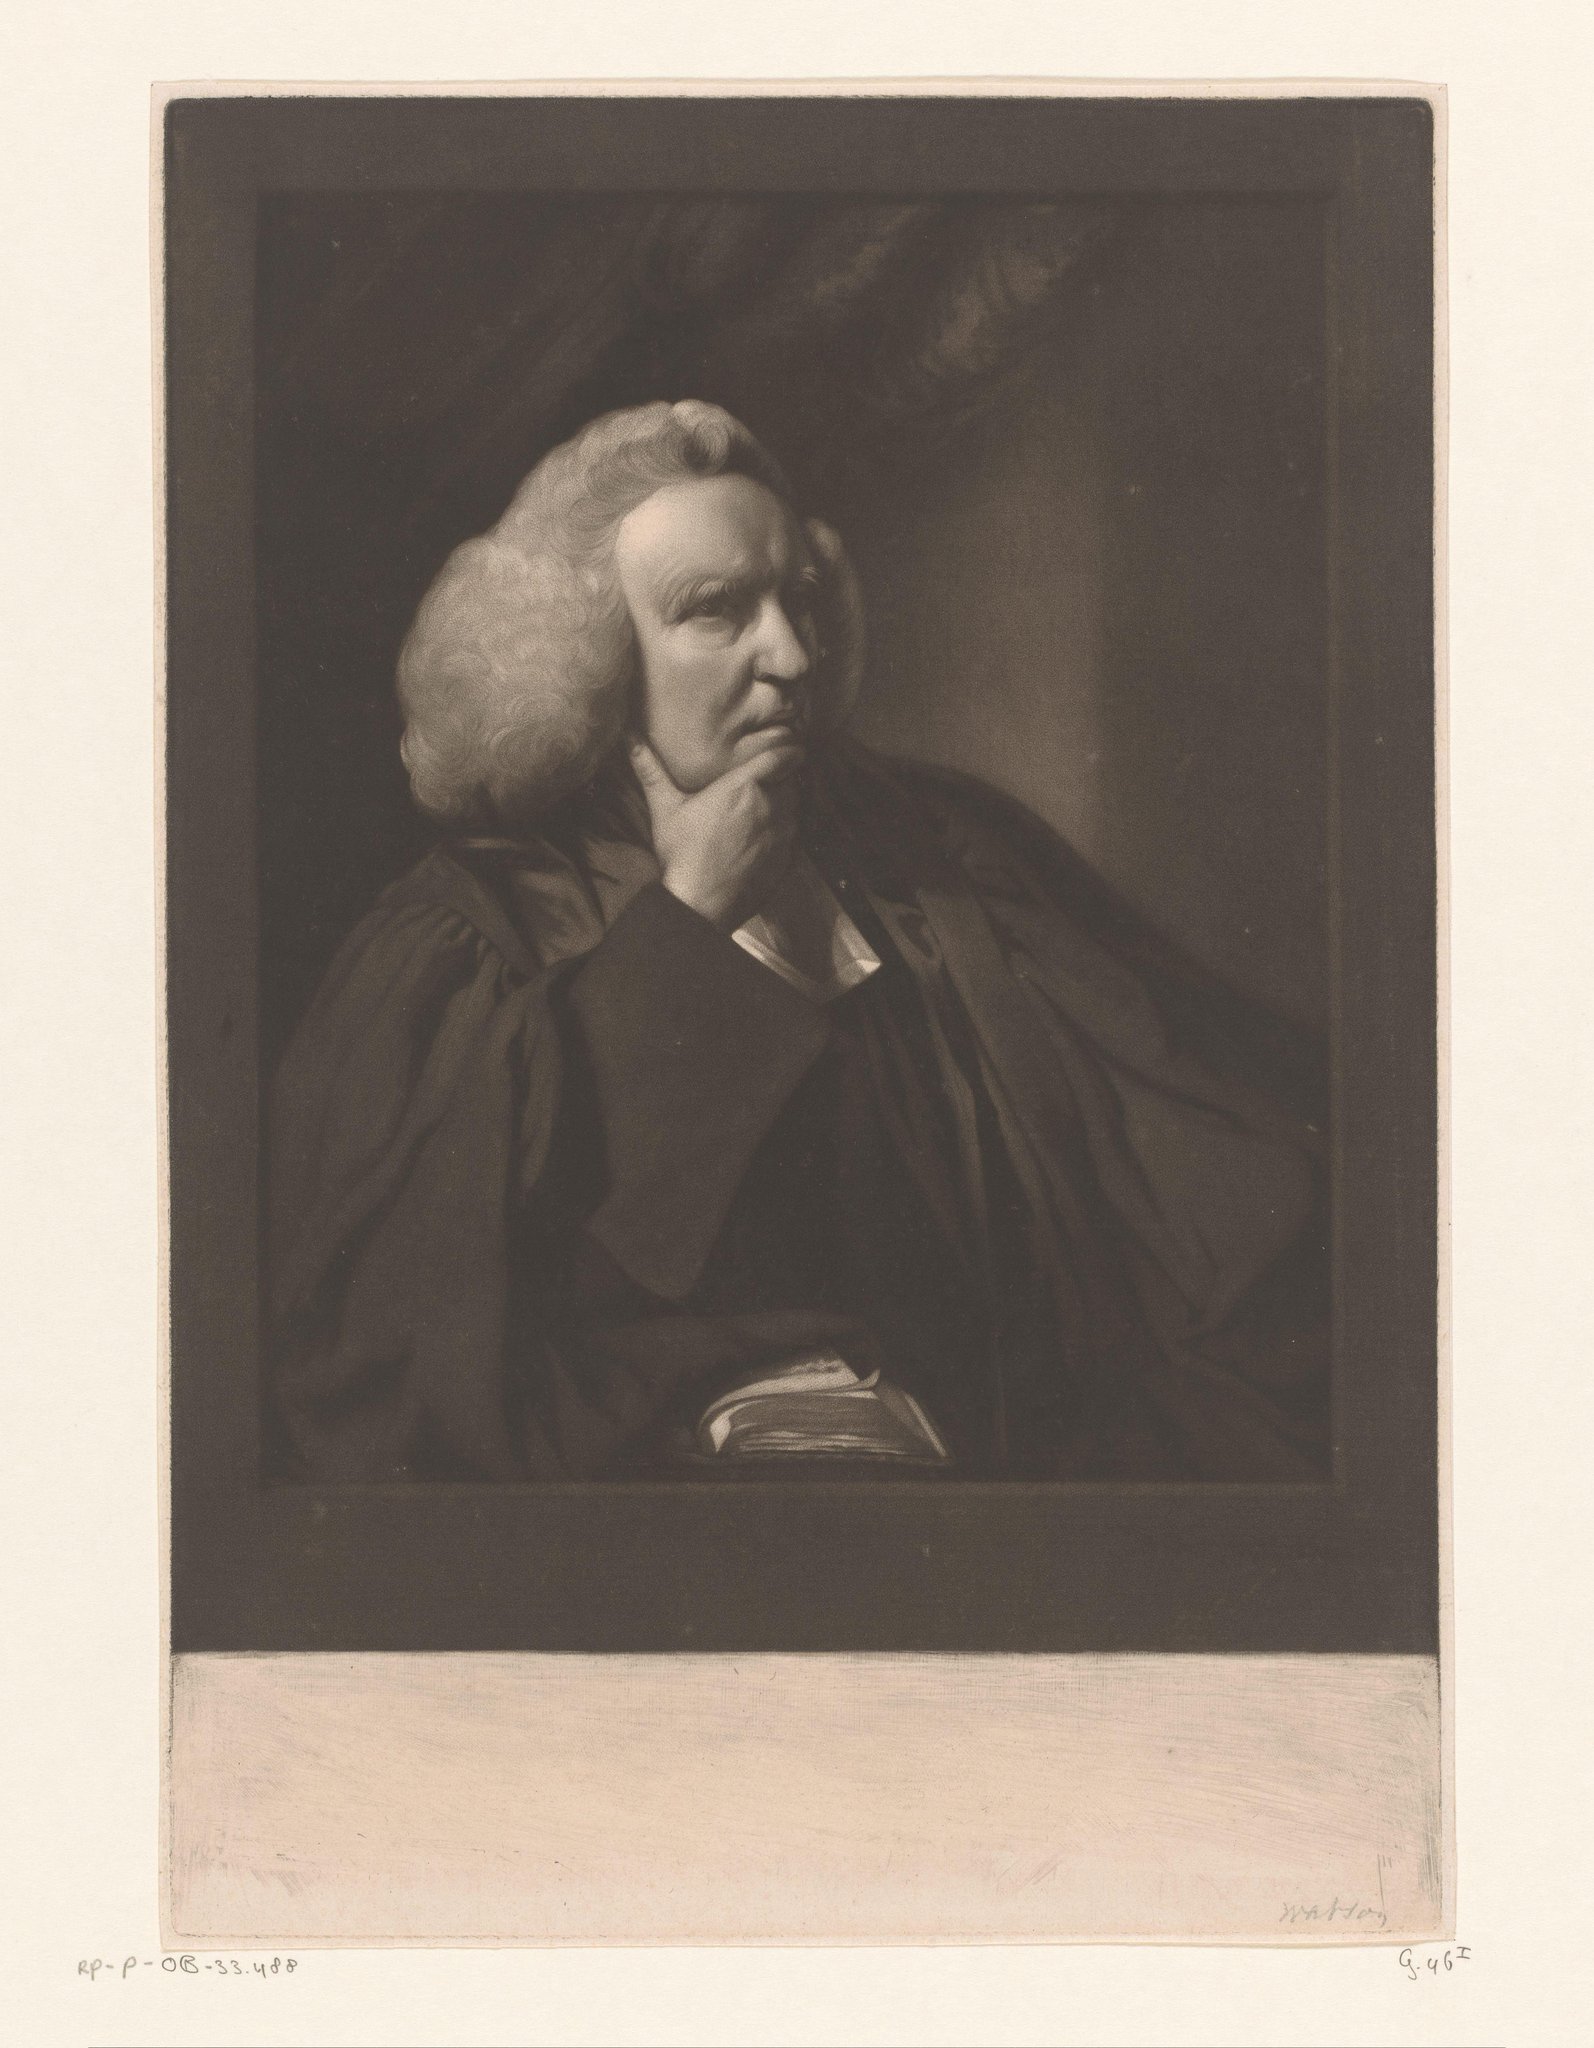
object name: print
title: Portret van Zachariah Mudge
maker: james watson (prentmaker)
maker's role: print maker, publisher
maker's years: 1740-1790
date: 1766-1768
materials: paper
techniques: mezzotint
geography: london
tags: clergyman, non-roman catholic episcopal churches, e.g. anglicans, historical persons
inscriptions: collector's mark: Lugt 240